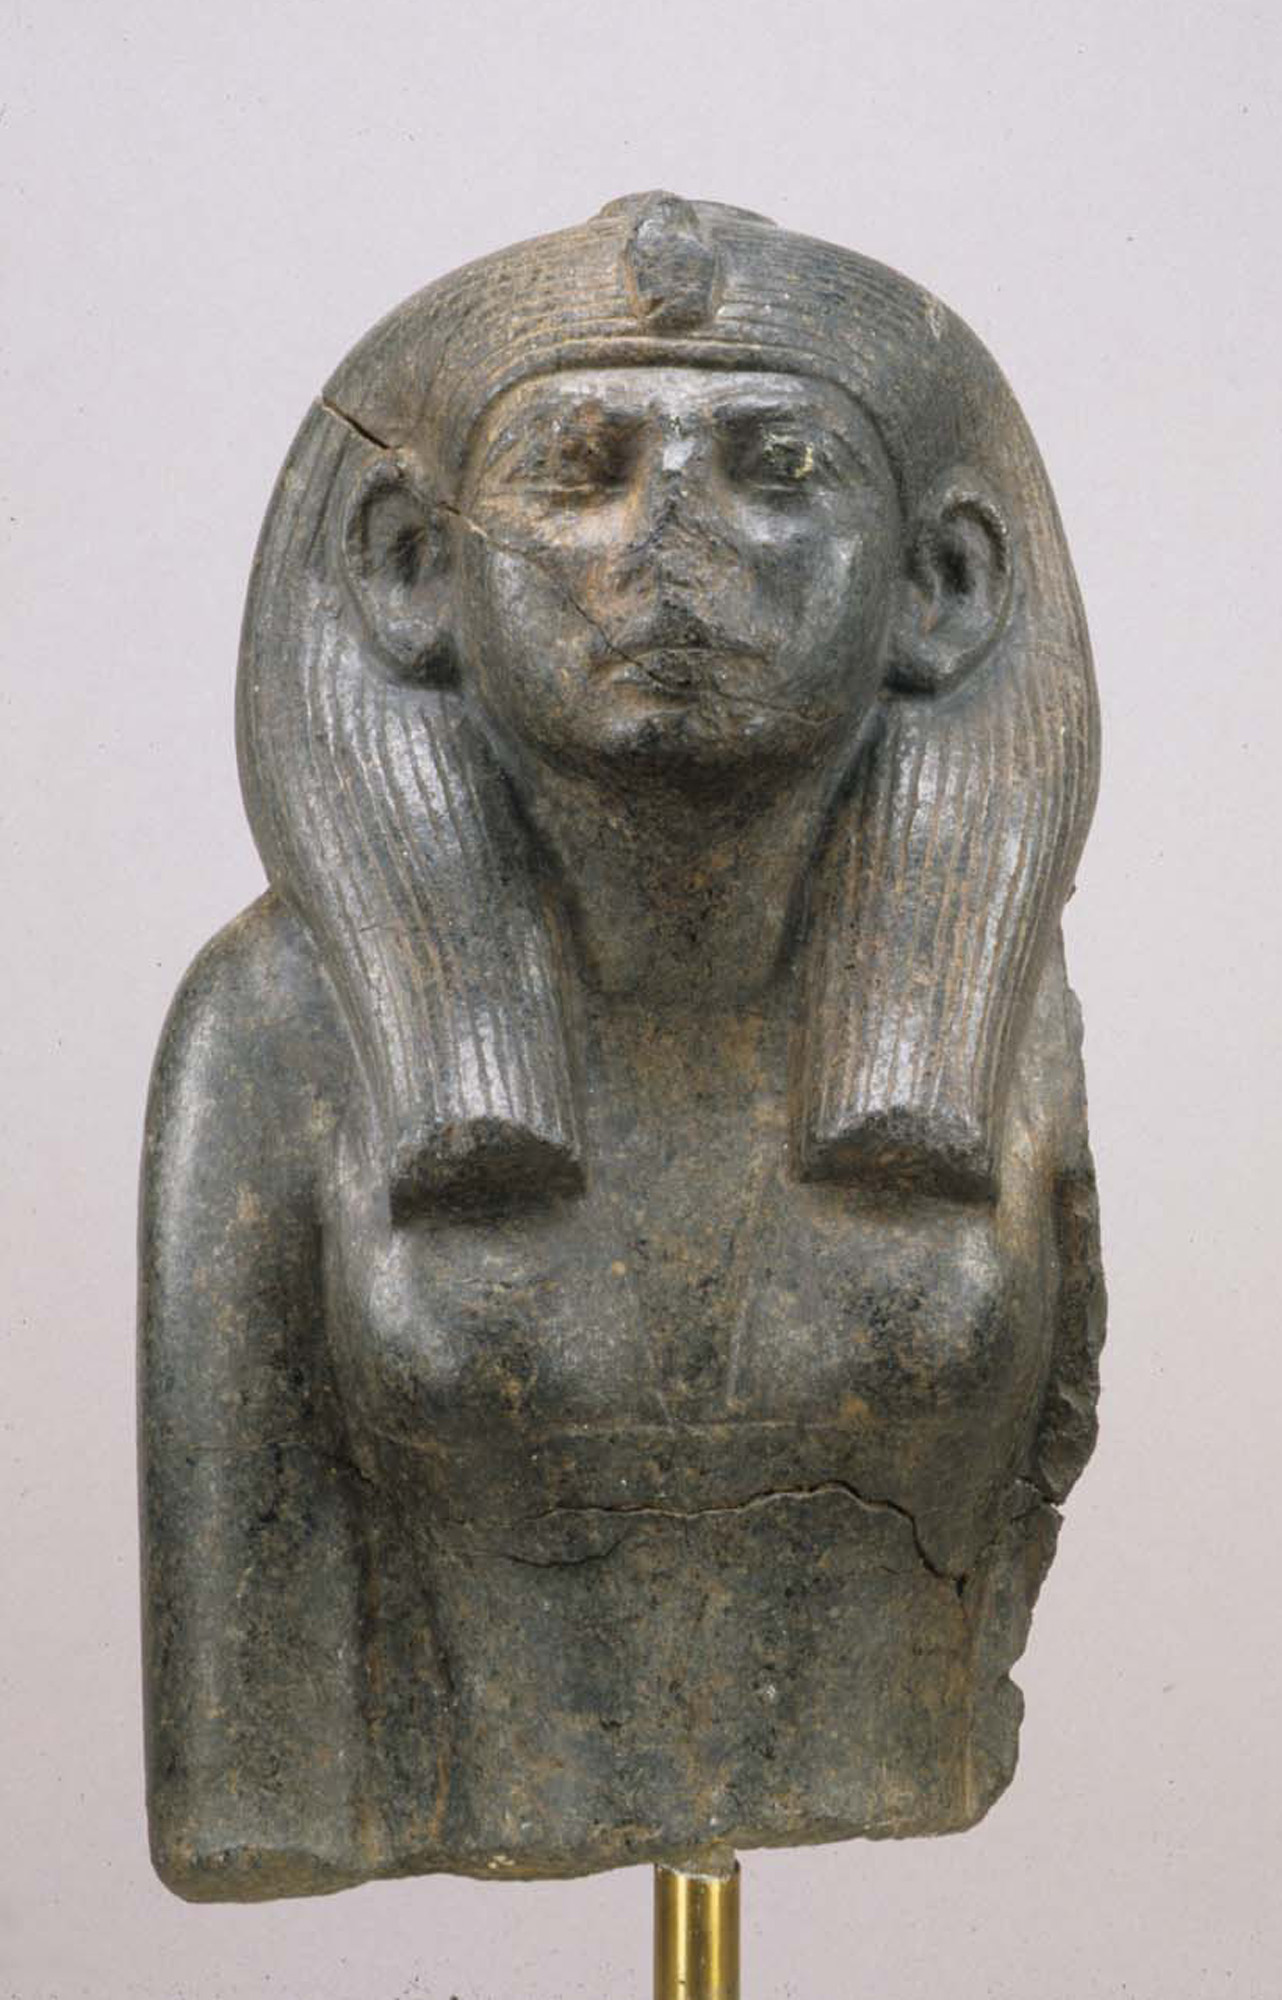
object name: statue, royal woman, upper half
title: A Royal Woman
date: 1919-1878 BCE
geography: egypt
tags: women